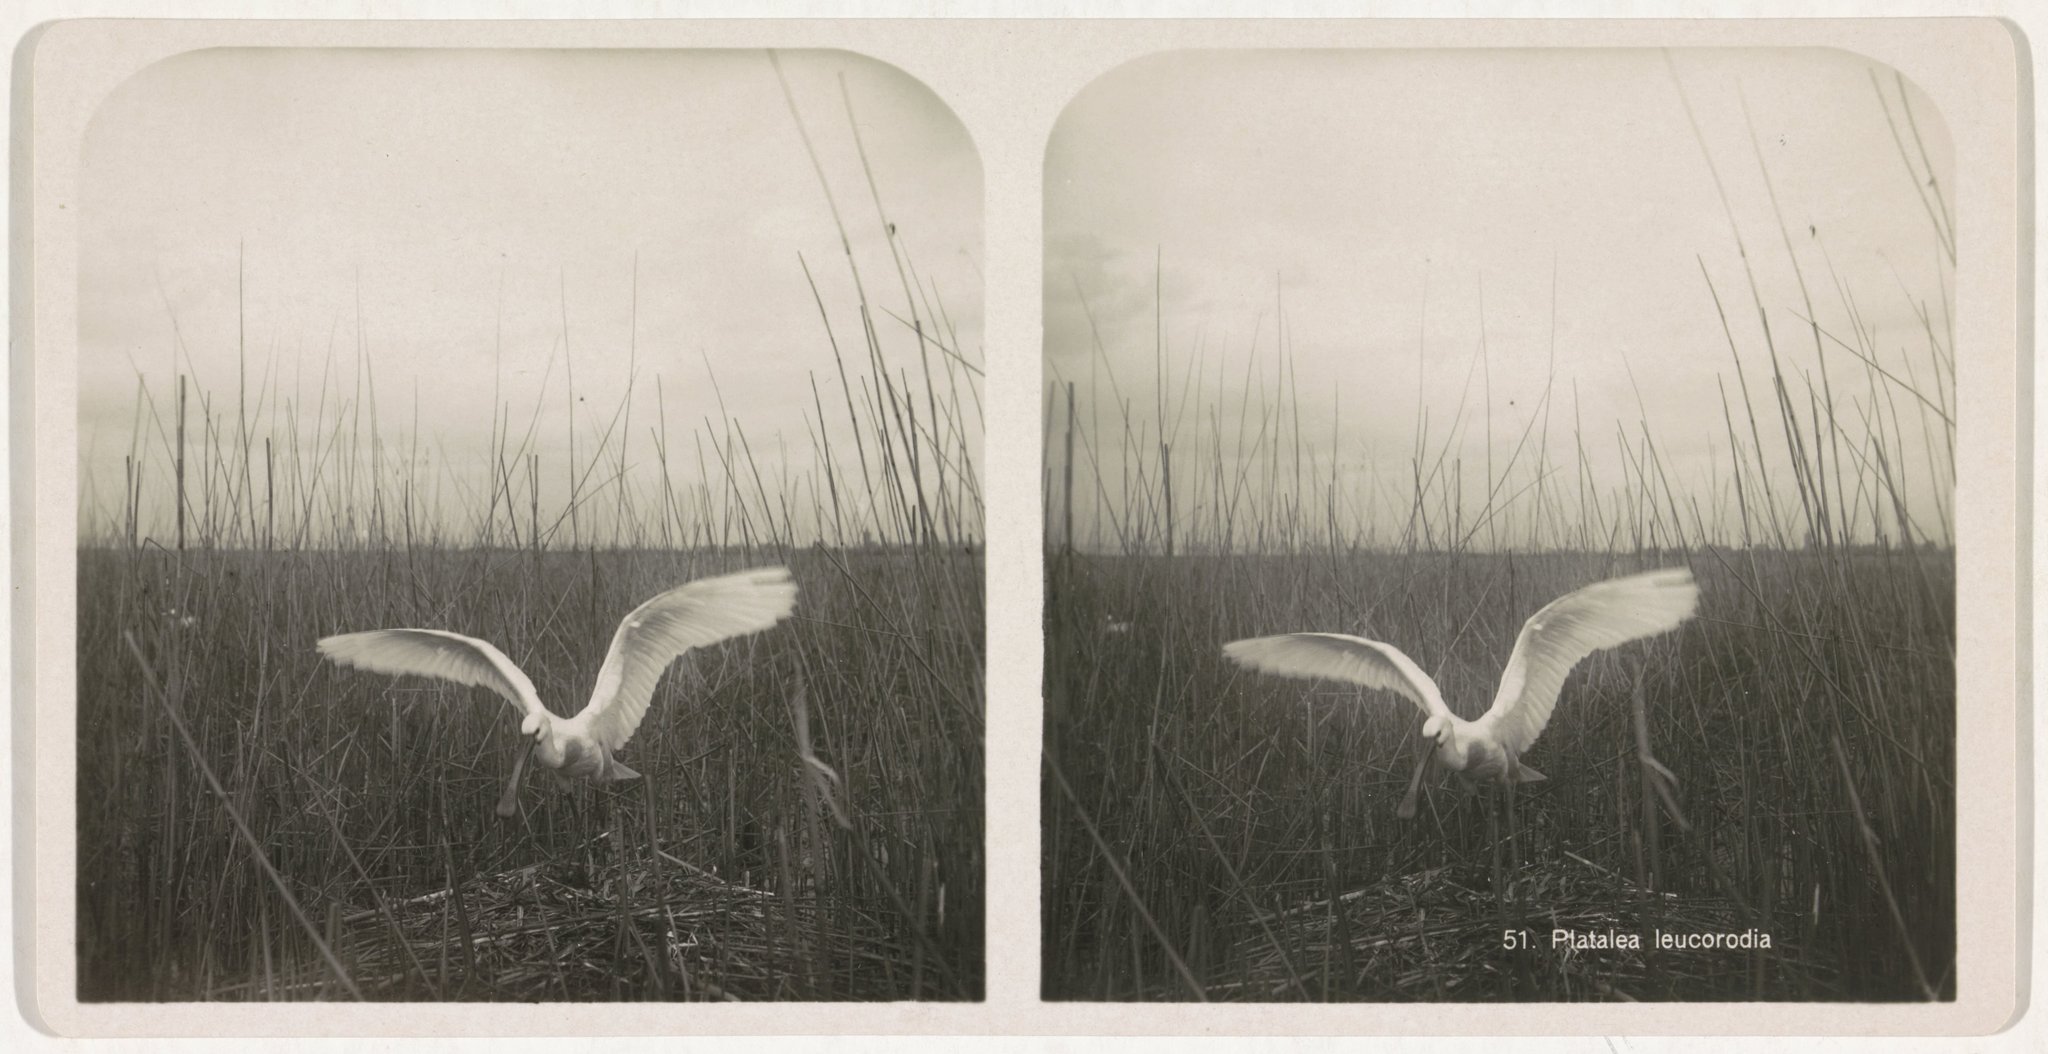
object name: photograph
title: Lepelaar met gespreide vleugels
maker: adolphe burdet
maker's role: fotograaf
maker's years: 1860-1940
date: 1870-1940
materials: photographic support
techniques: gelatin silver print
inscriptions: label: ‘Lepelaars’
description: De foto is afkomstig uit een serie van 12 stereofoto's met moerasvogels die bewaard worden in het originele mapje. Bij dit mapje zit ook een blaadje met informatie over de vogels.